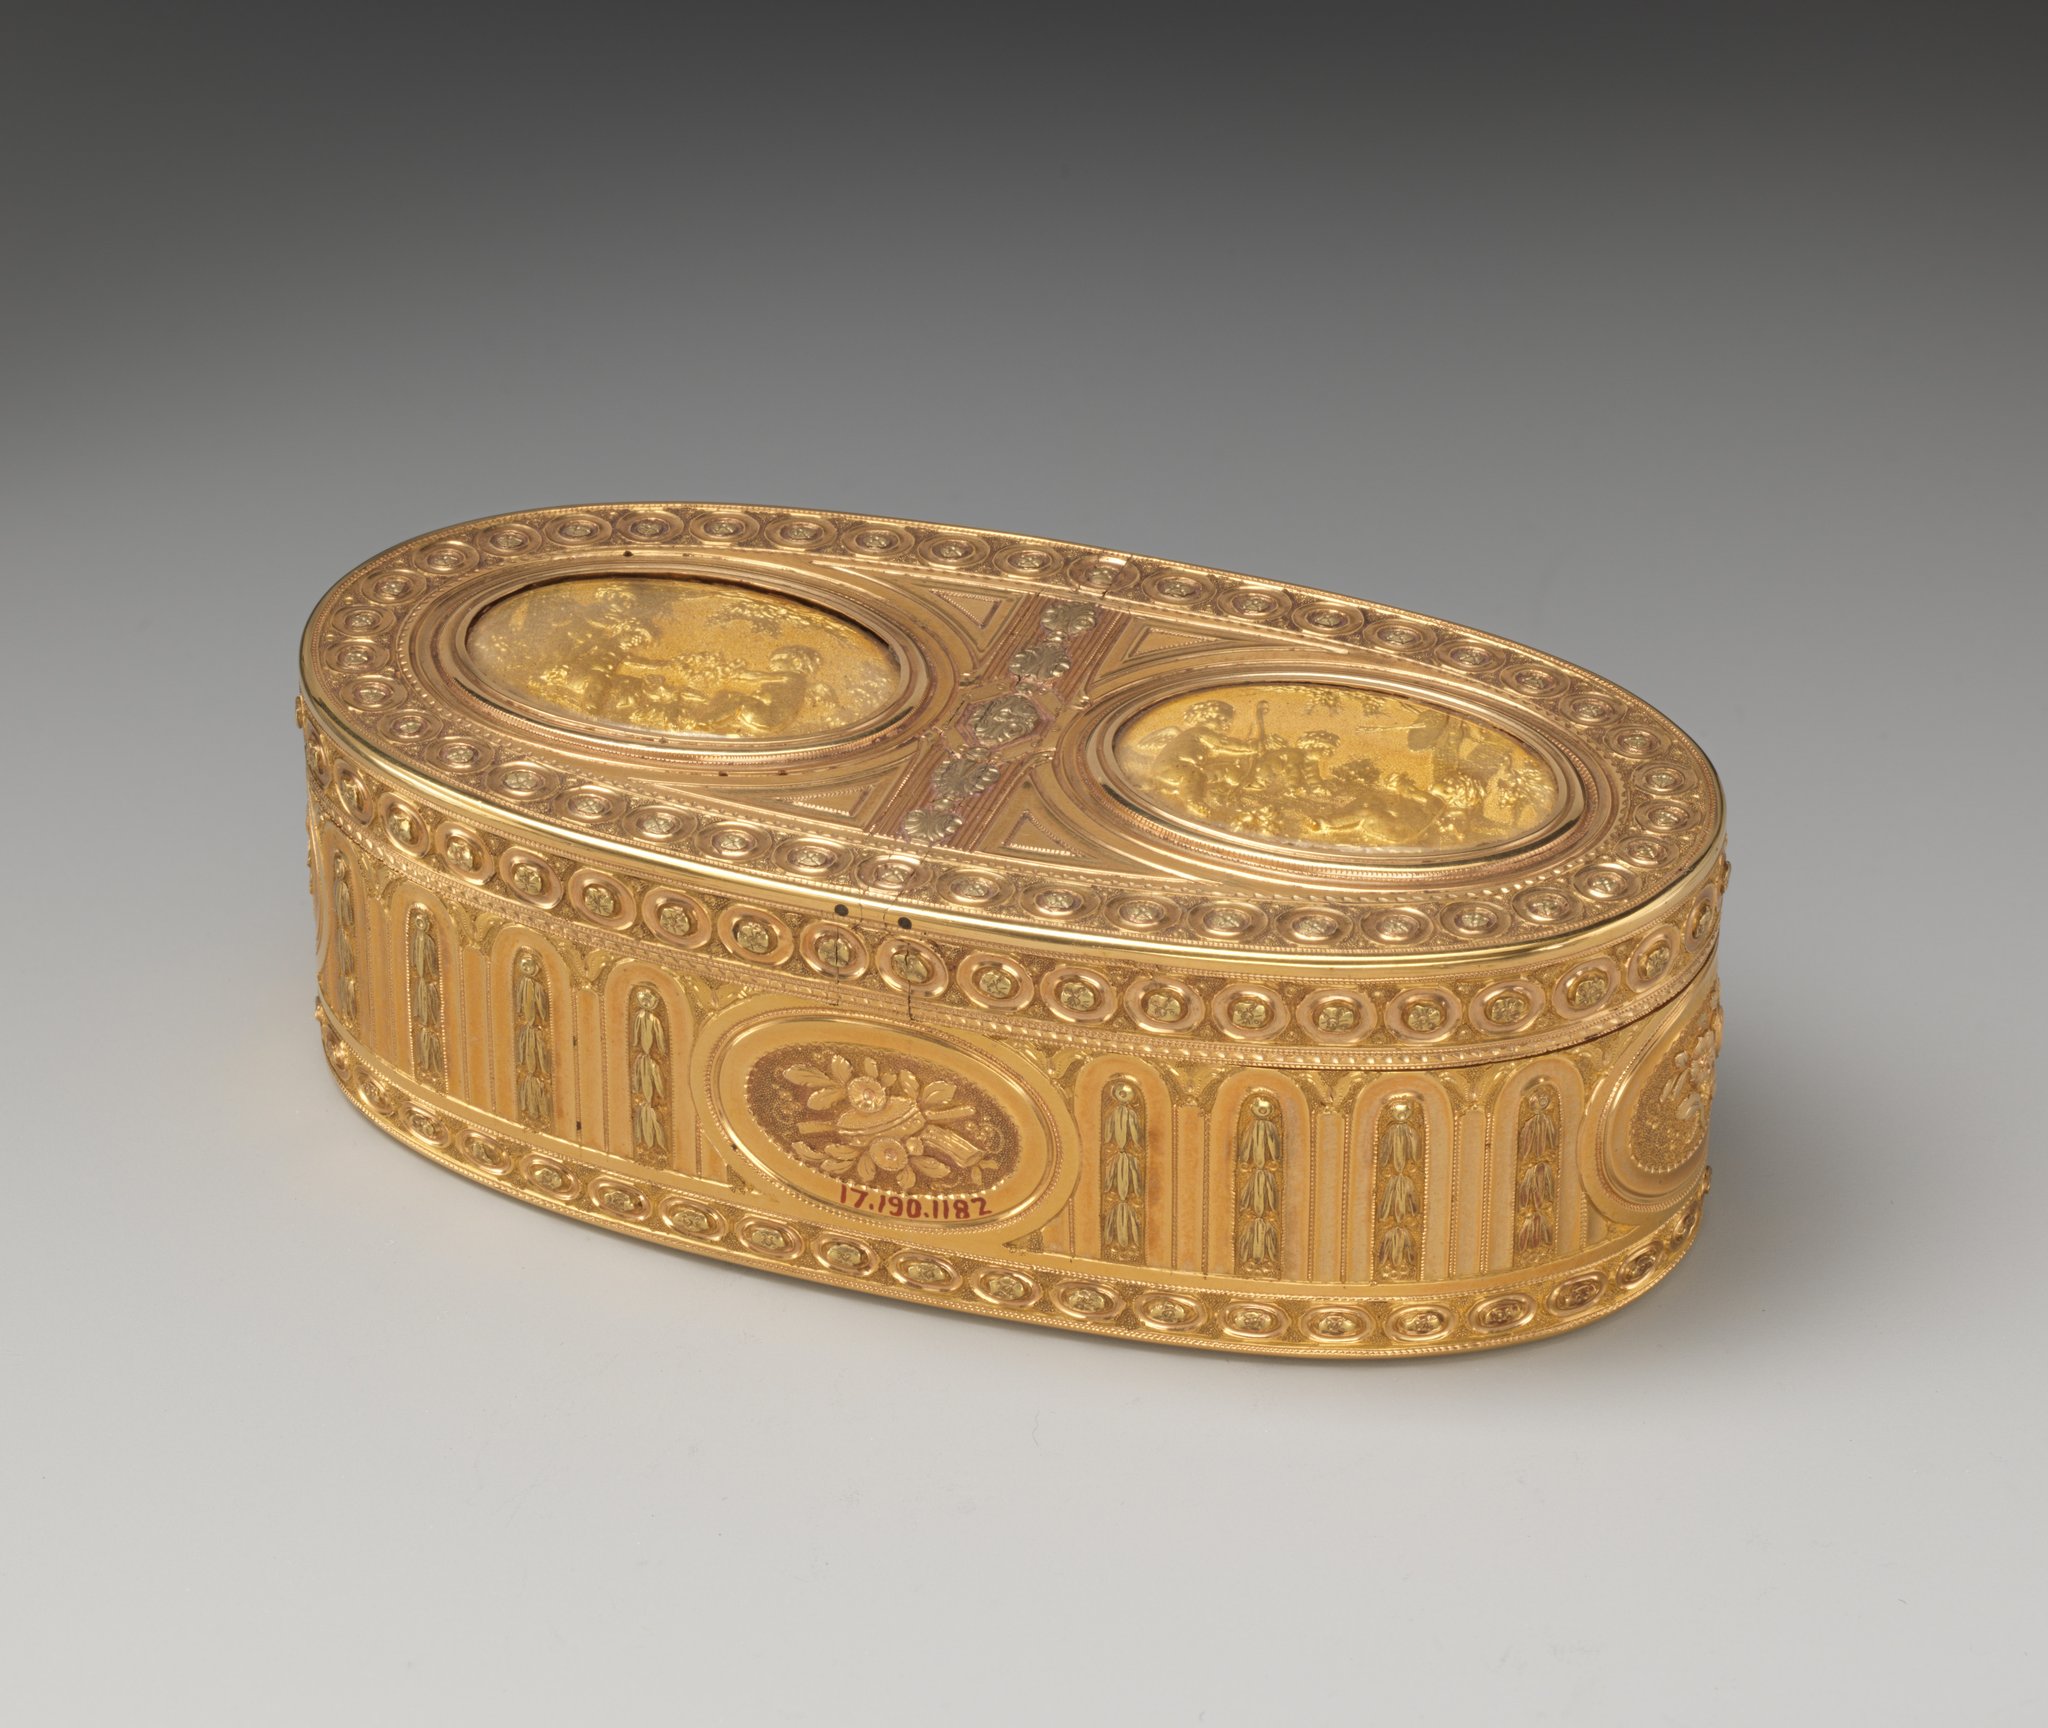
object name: snuffbox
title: Double snuffbox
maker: melchior-rené barré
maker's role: maker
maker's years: 1738-1791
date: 1771-1772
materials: glass, gold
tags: putti